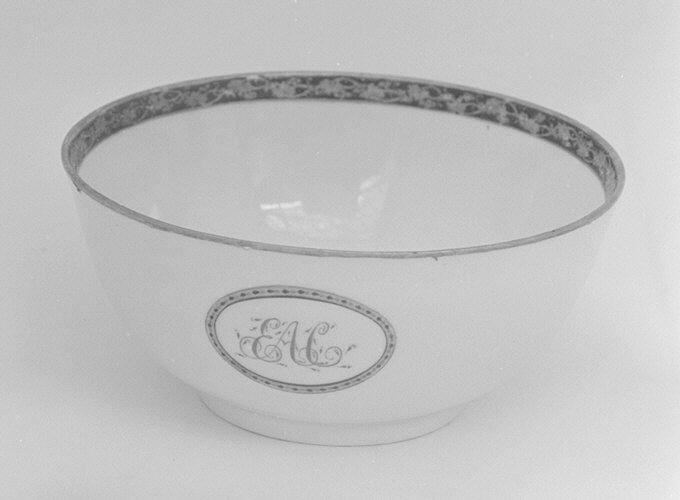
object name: bowl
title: Bowl (part of a service)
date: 1790-1800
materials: hard paste porcelain